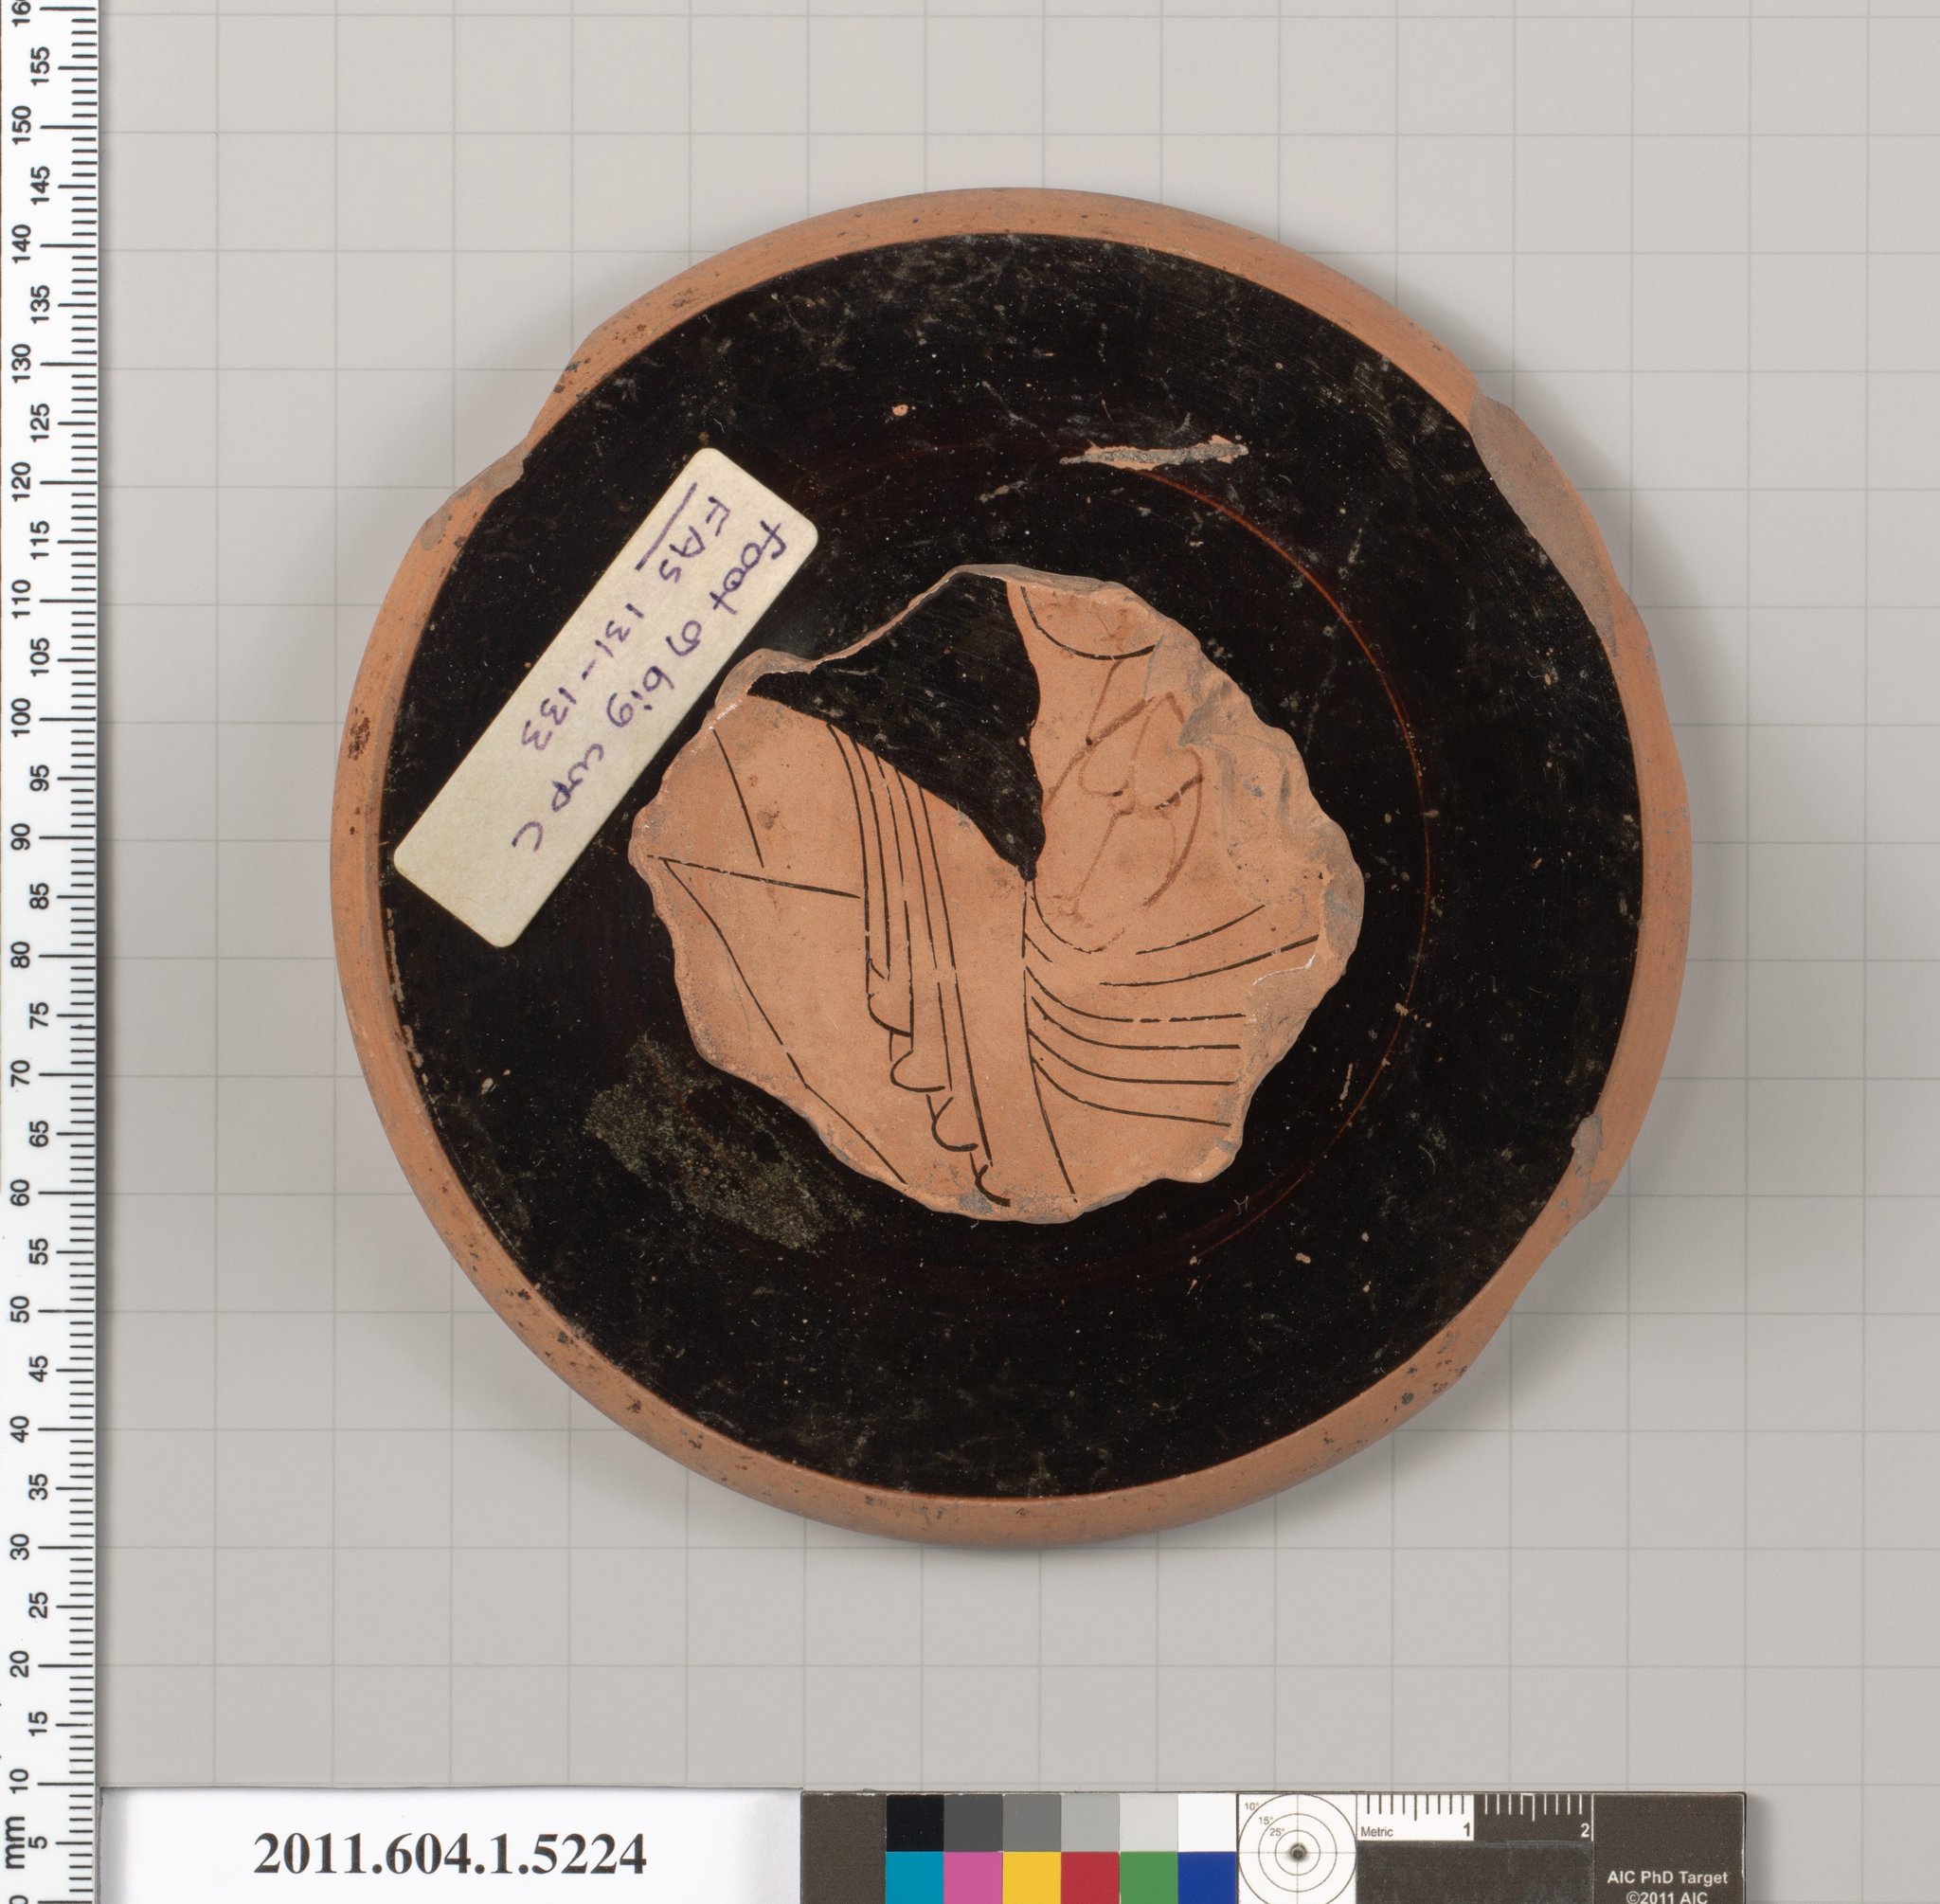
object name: kylix fragment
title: Terracotta fragment of a kylix (drinking cup)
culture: greek, attic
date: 520-500 BCE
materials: terracotta